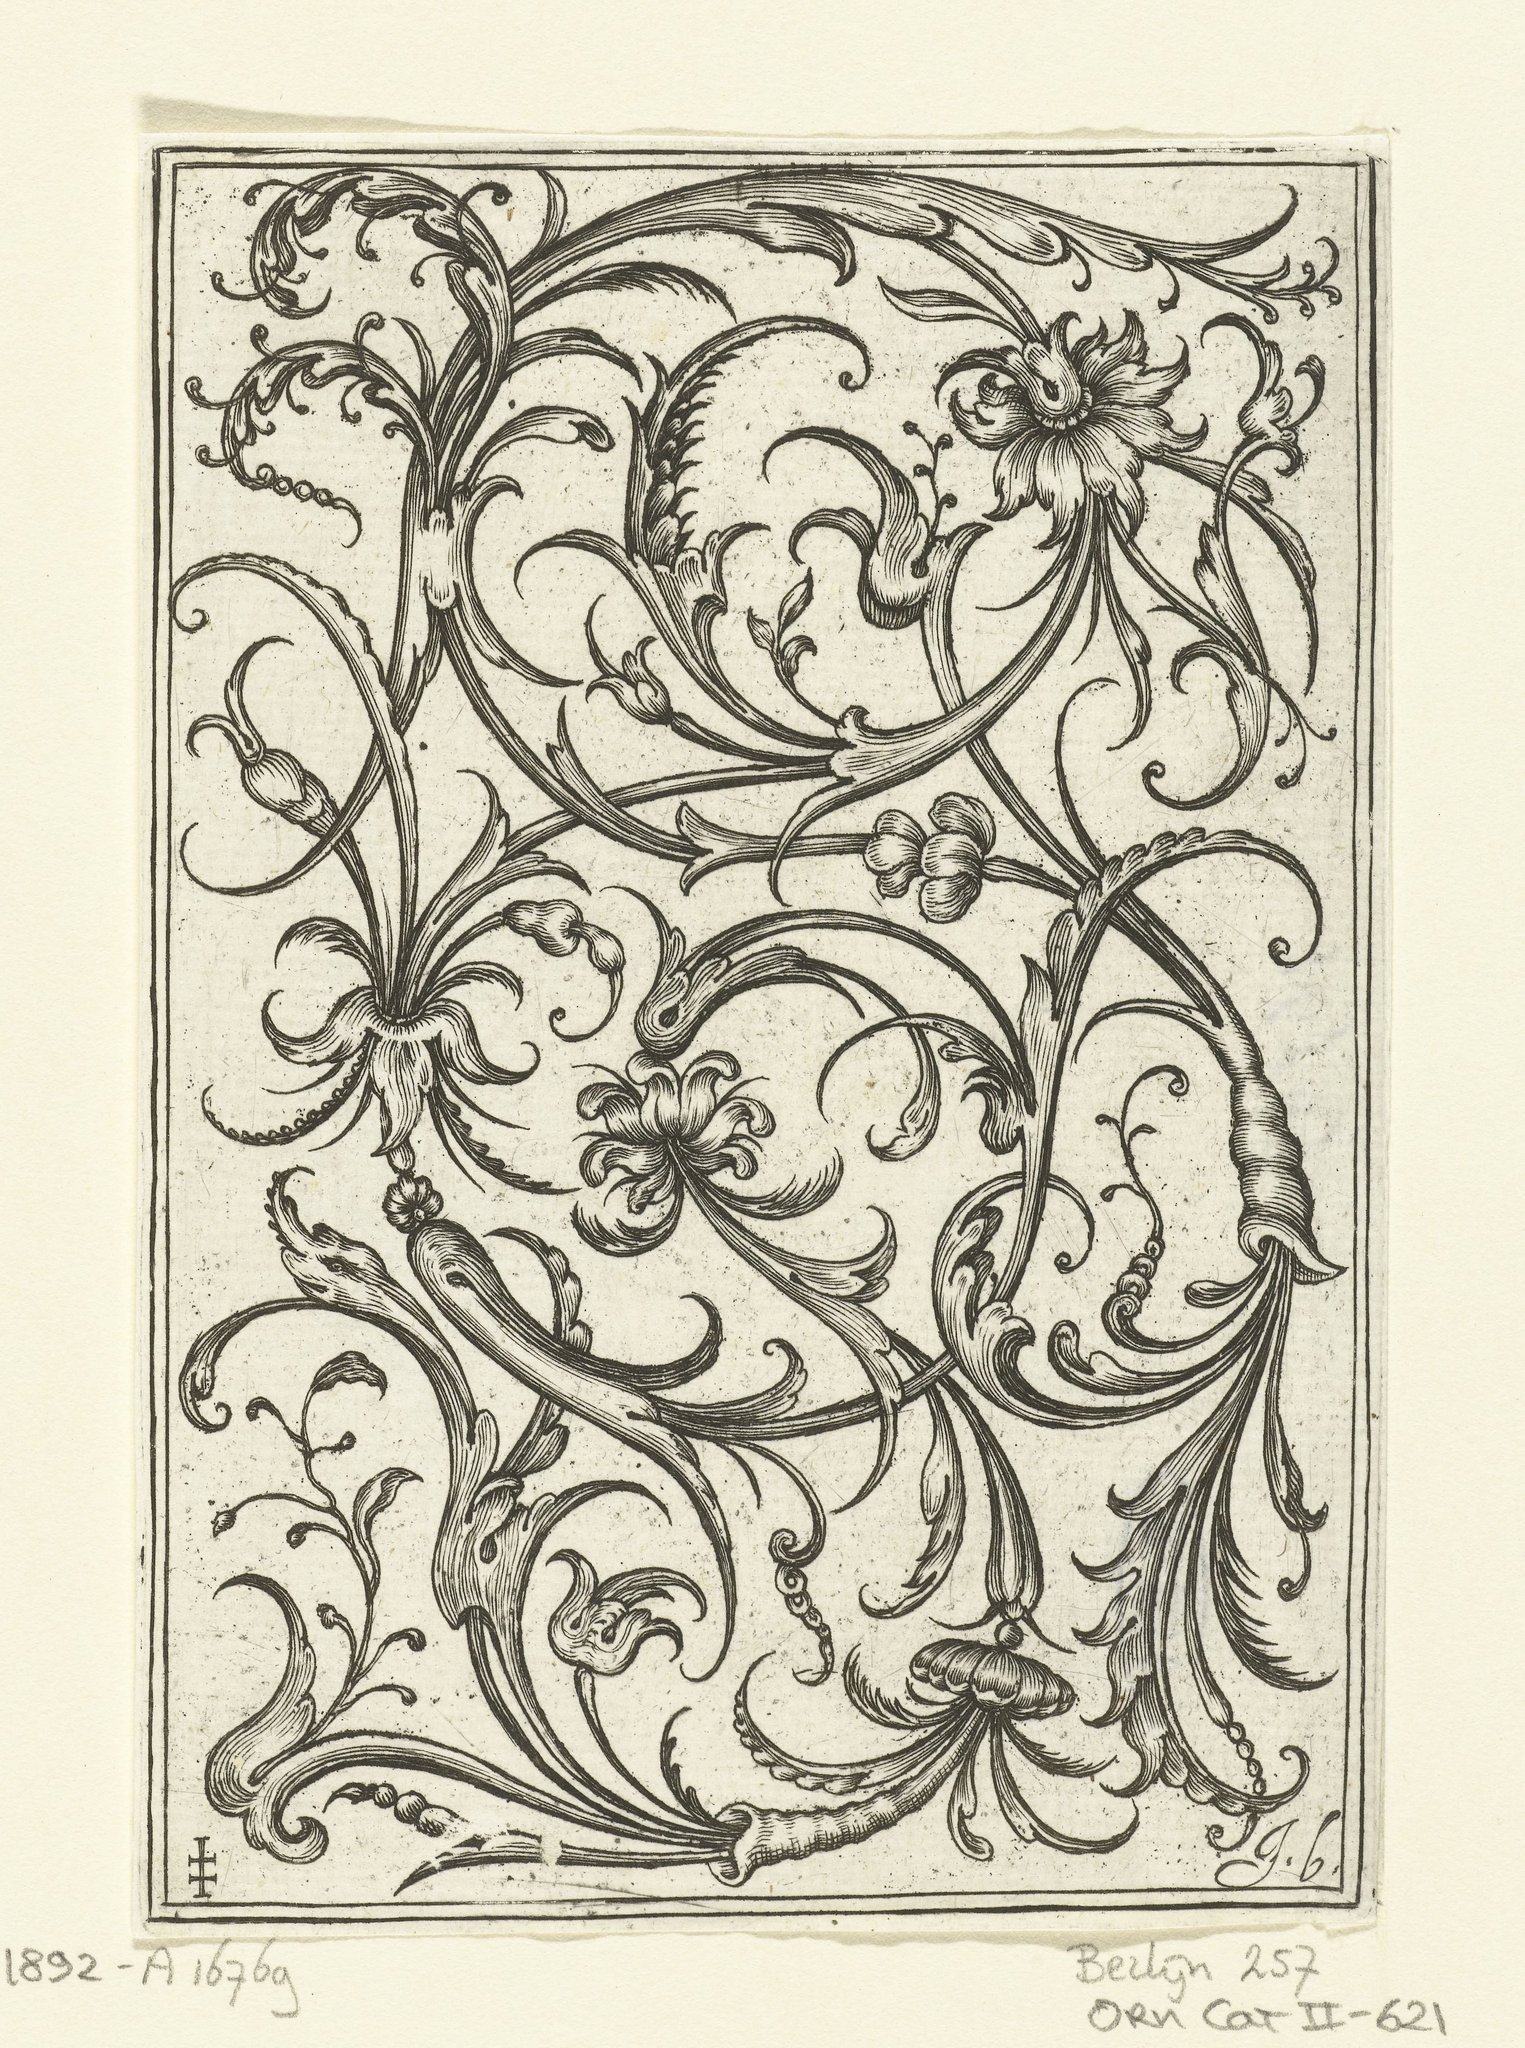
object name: print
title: Paneel met bladranken en bloemen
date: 1623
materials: paper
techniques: engraving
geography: london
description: Uit serie van 12 bladen met bladranken en grotesken, opgedragen aan George Henriot.